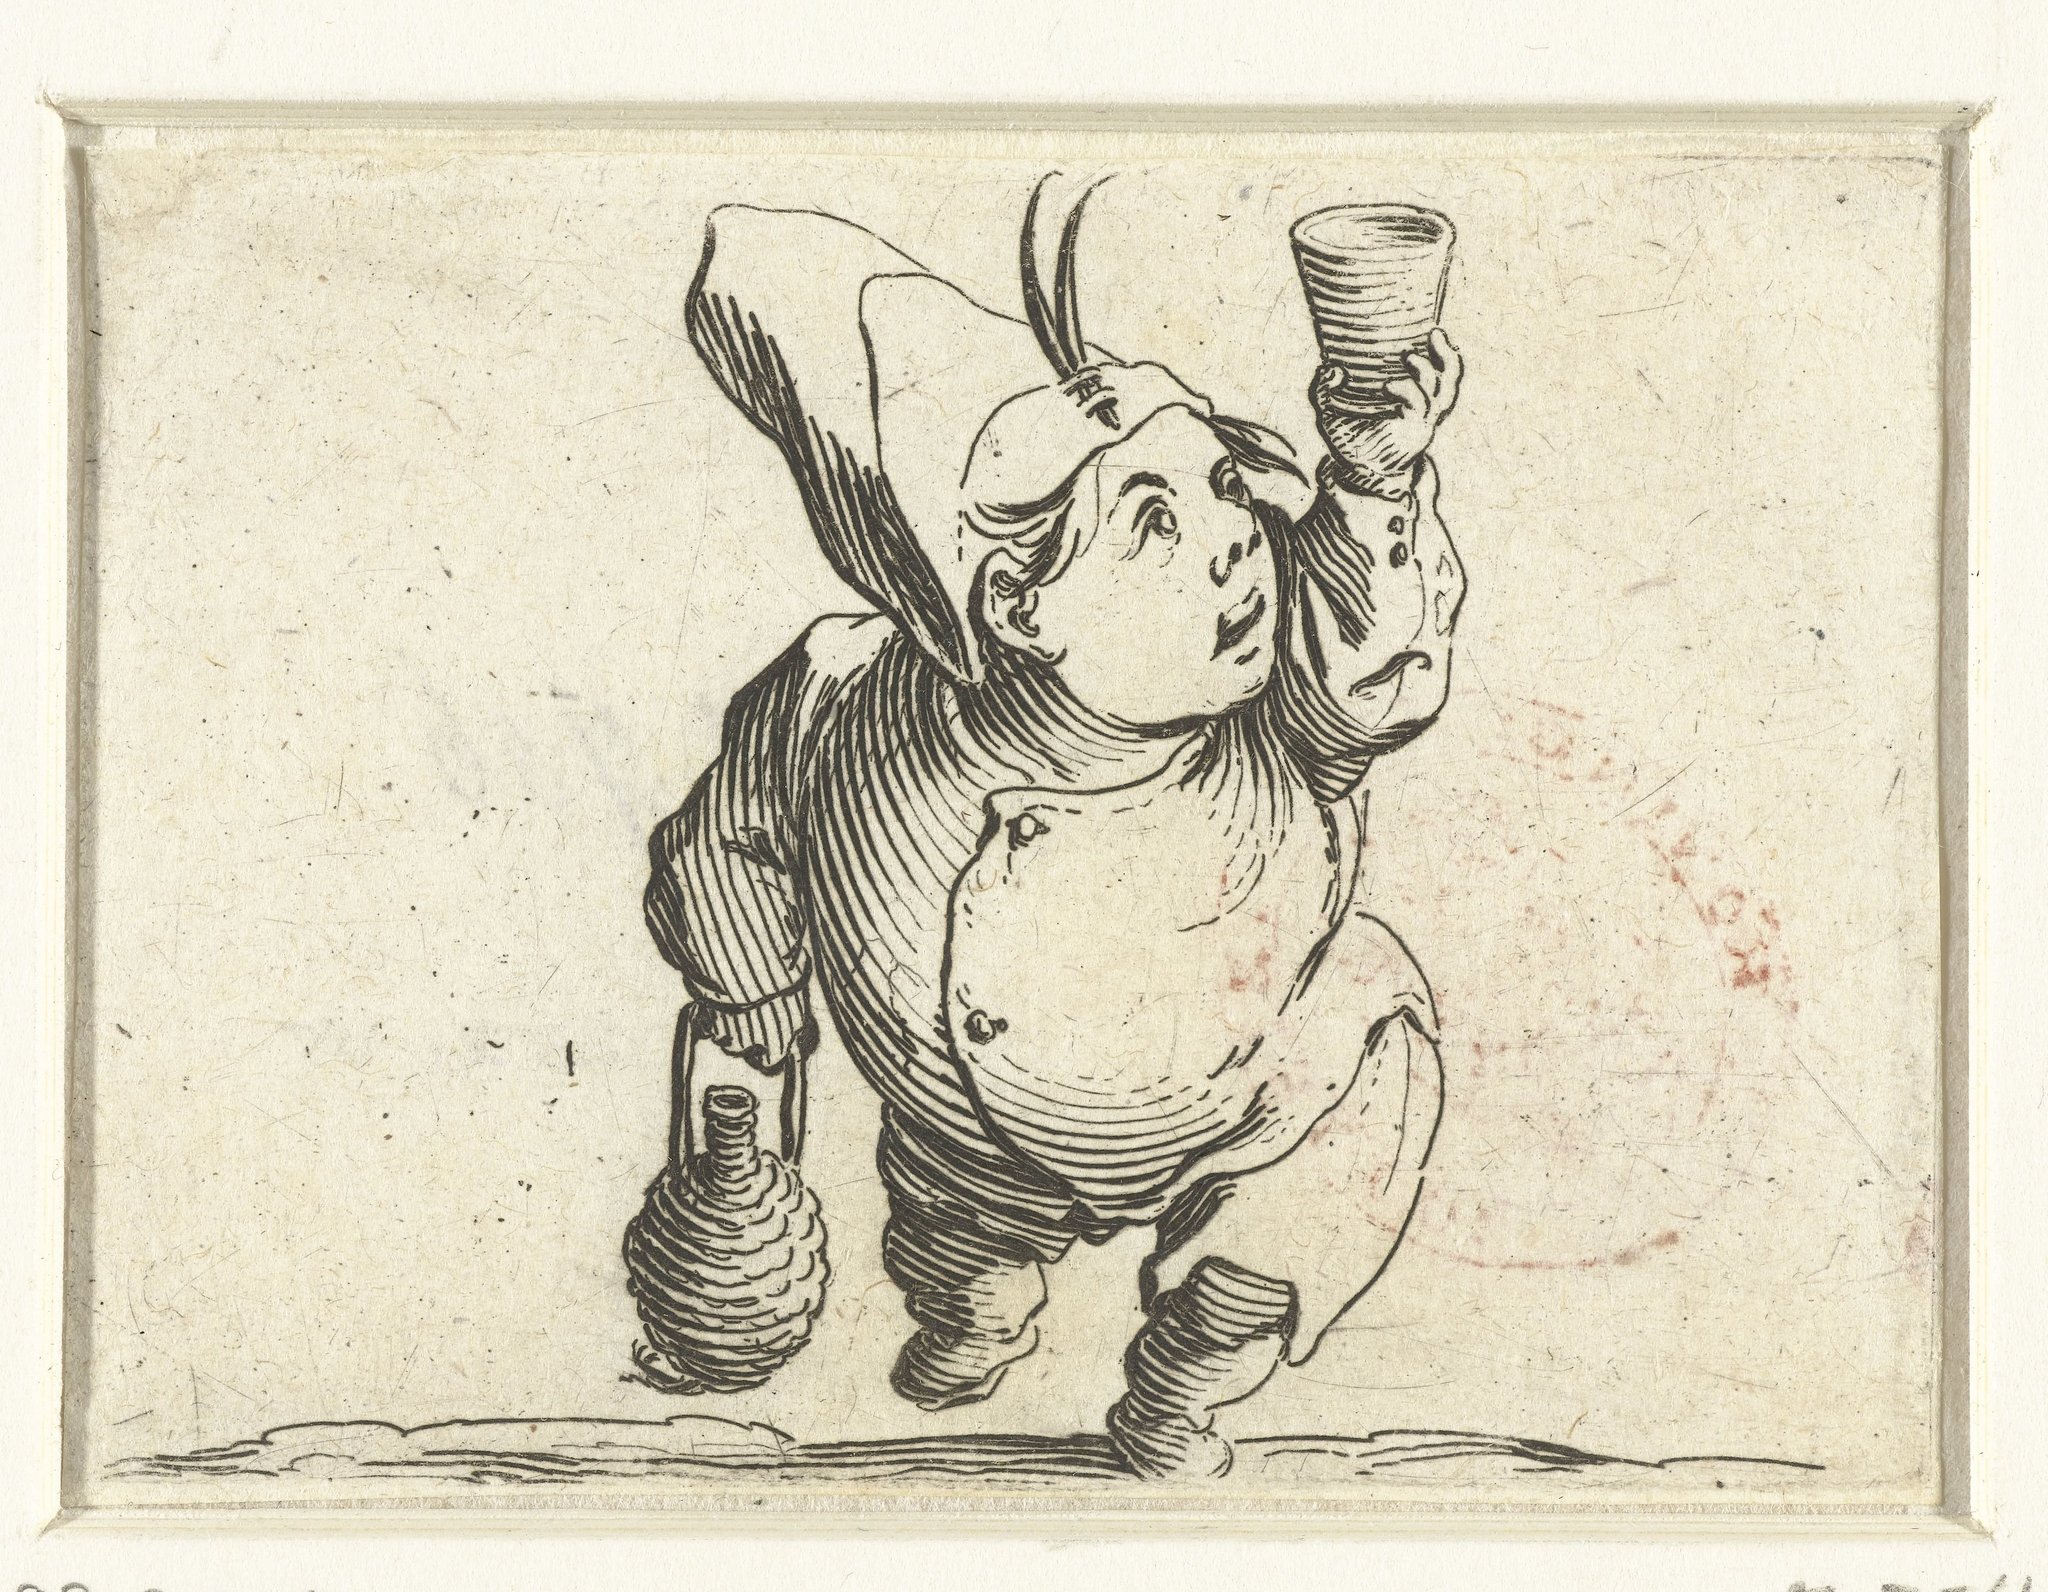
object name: print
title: Kleine mens (karikatuur) met fles en glas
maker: jacques callot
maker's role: draughtsman, print maker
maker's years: 1592-1635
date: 1621-1625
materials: paper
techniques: engraving, etching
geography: nancy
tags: little people, glass, rummer, container of glass: bottle, jar, vase, bottle of wine, glass of wine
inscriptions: collector's mark: Lugt 240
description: Een kleine mens (karikatuur), van voren gezien, een hoge hoed met twee veren op het hoofd, in de rechterhand een fles, in de linkerhand een glas. Deze prent is onderdeel van een serie van 21 prenten met groteske figuren; vrijwel al die figuren zijn karikaturen van kleine mensen, velen zijn gebocheld.